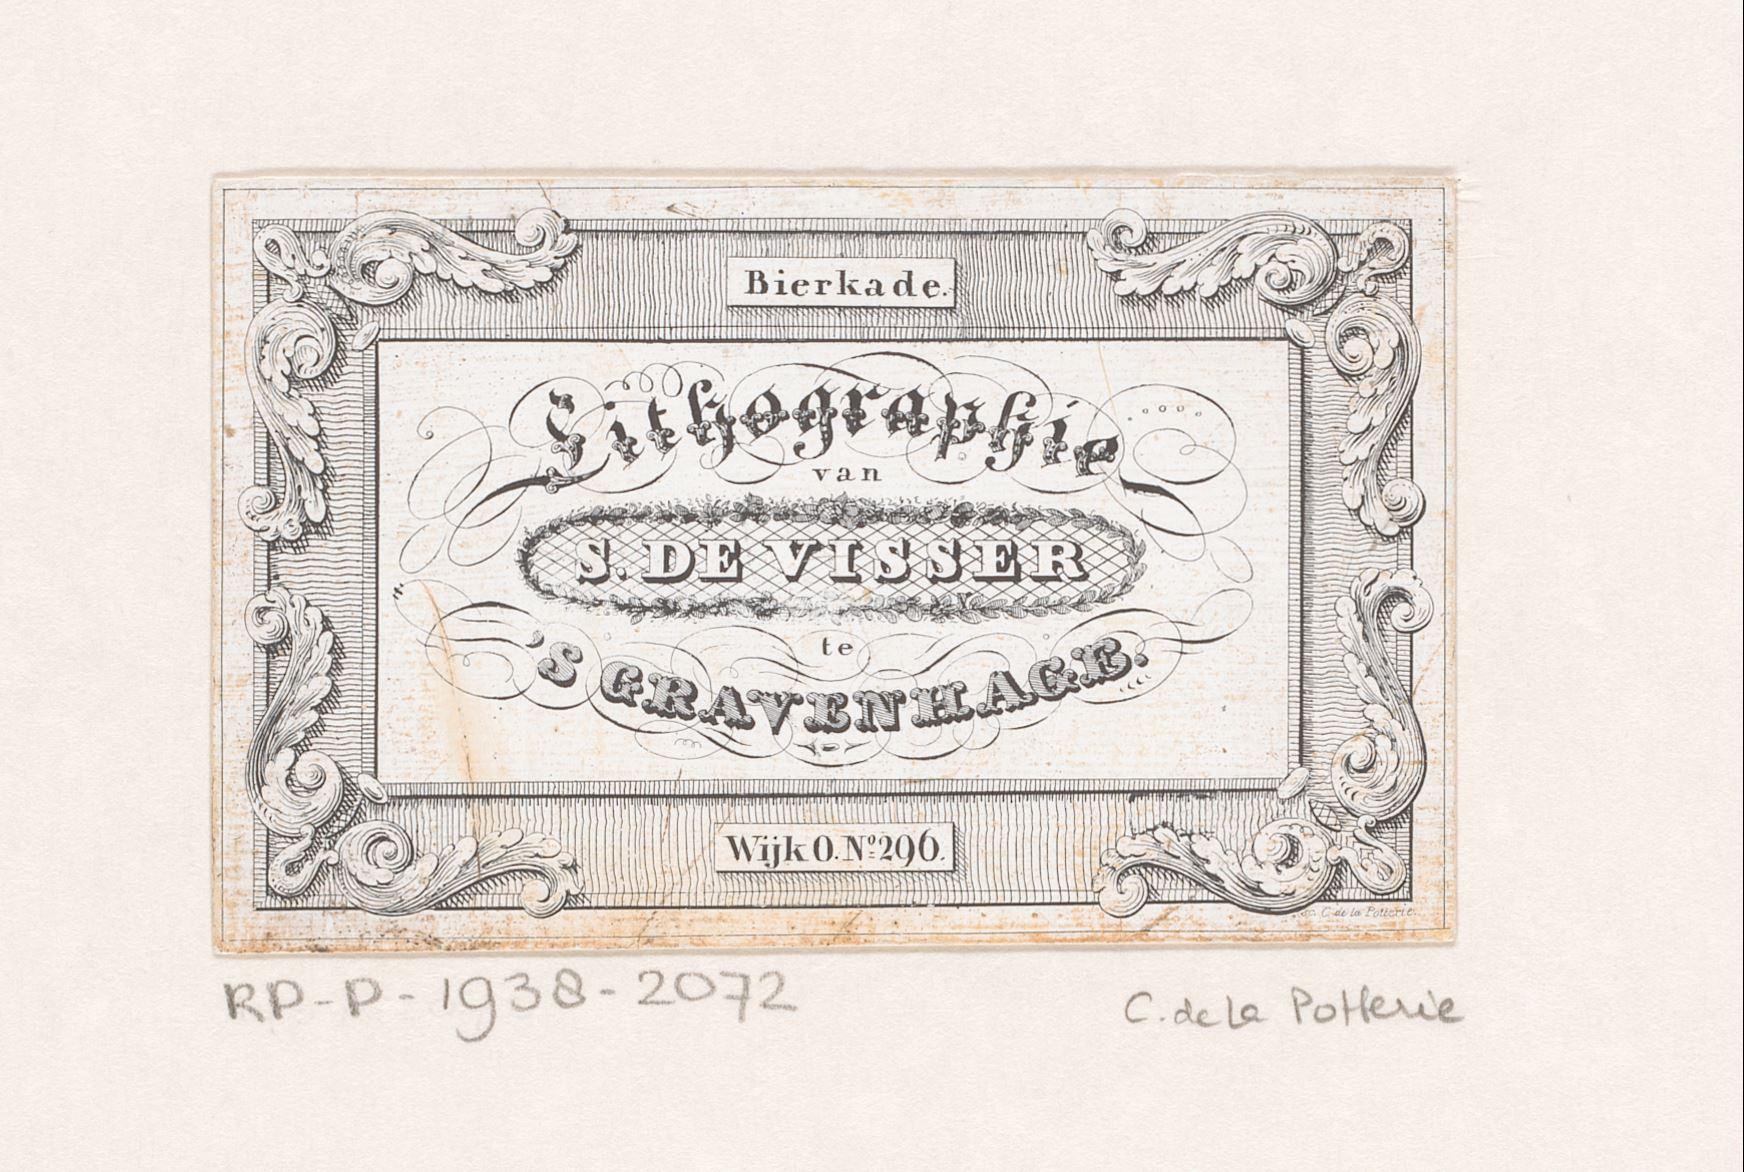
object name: print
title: Lithographie van S. de Visser te 's Gravenhage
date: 1835-1839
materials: paper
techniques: lithograph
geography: the hague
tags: ornaments ~ art (+ framing decorations)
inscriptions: collector's mark: Lugt 2166, collector's mark: Lugt 2760